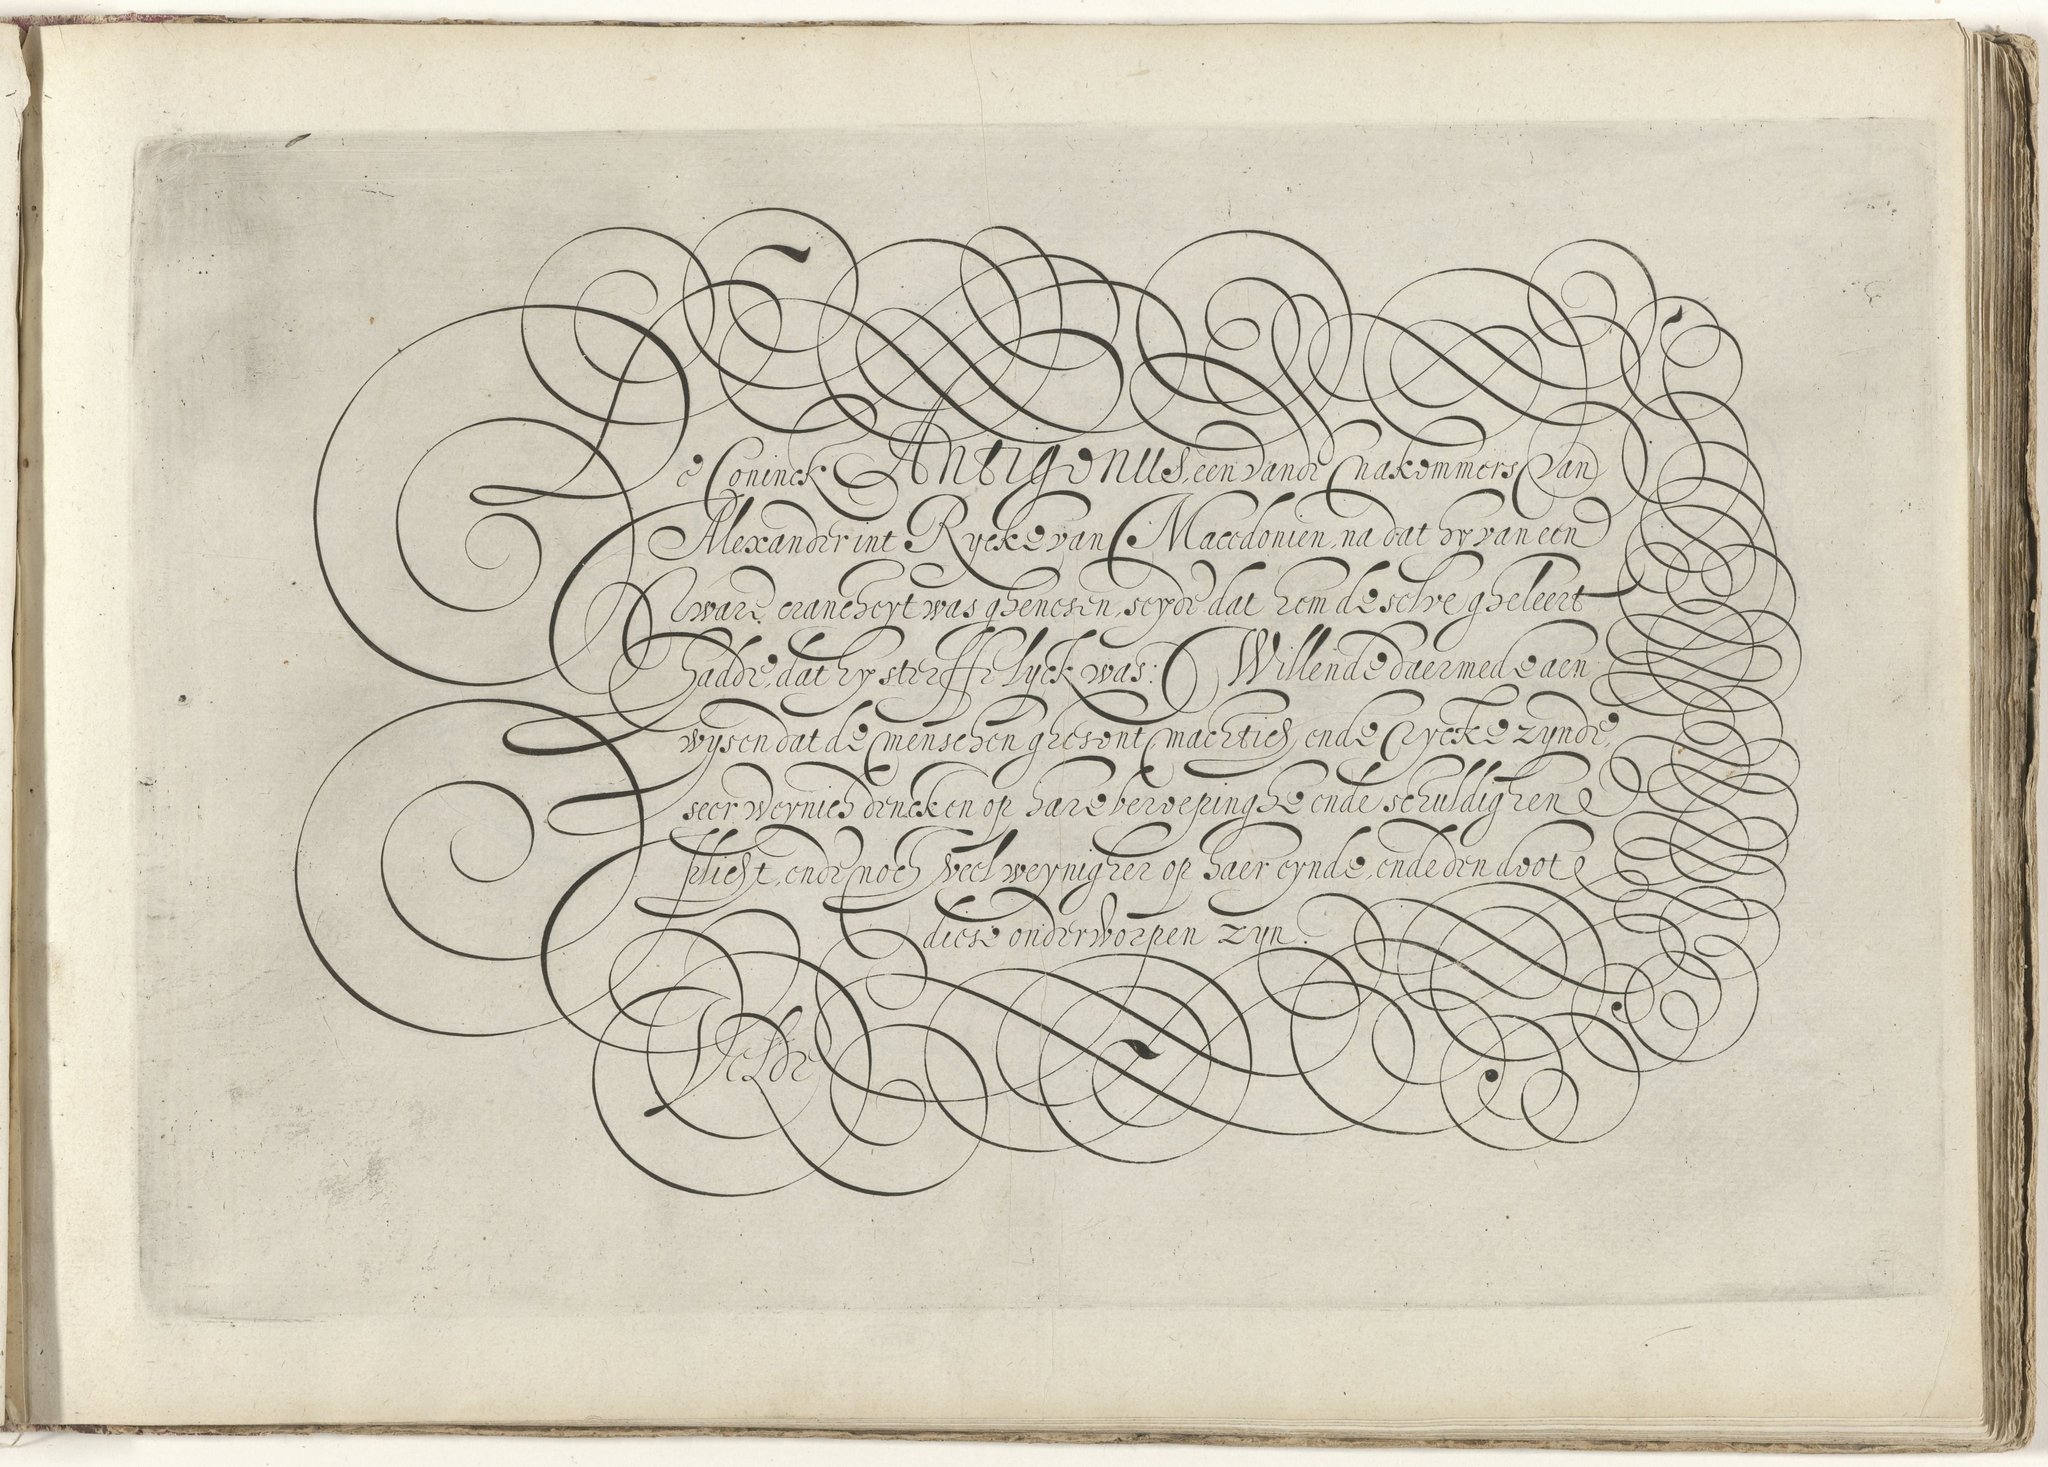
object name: print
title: Spieghel der schrijfkonste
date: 1605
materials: paper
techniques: engraving, intaglio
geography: amsterdam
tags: calligraphy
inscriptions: collector's mark: Lugt 2760, collector's mark: Lugt 2228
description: Schrijfvoorbeeld met acht regels tekst in het Nederlands: De coninck Antigonus ... De tekst is omlijst met krulwerk. De prent maakt deel uit van een album.